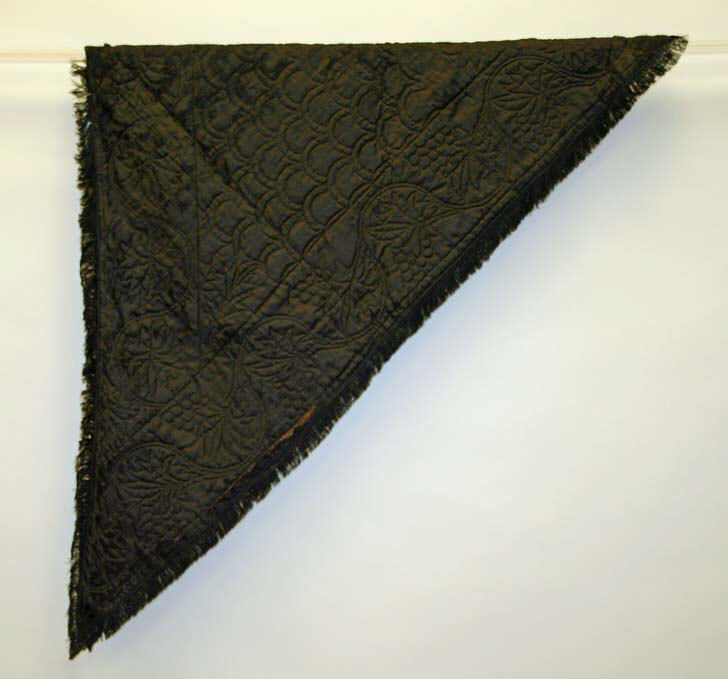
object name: shawl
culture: american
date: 1834-1866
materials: silk